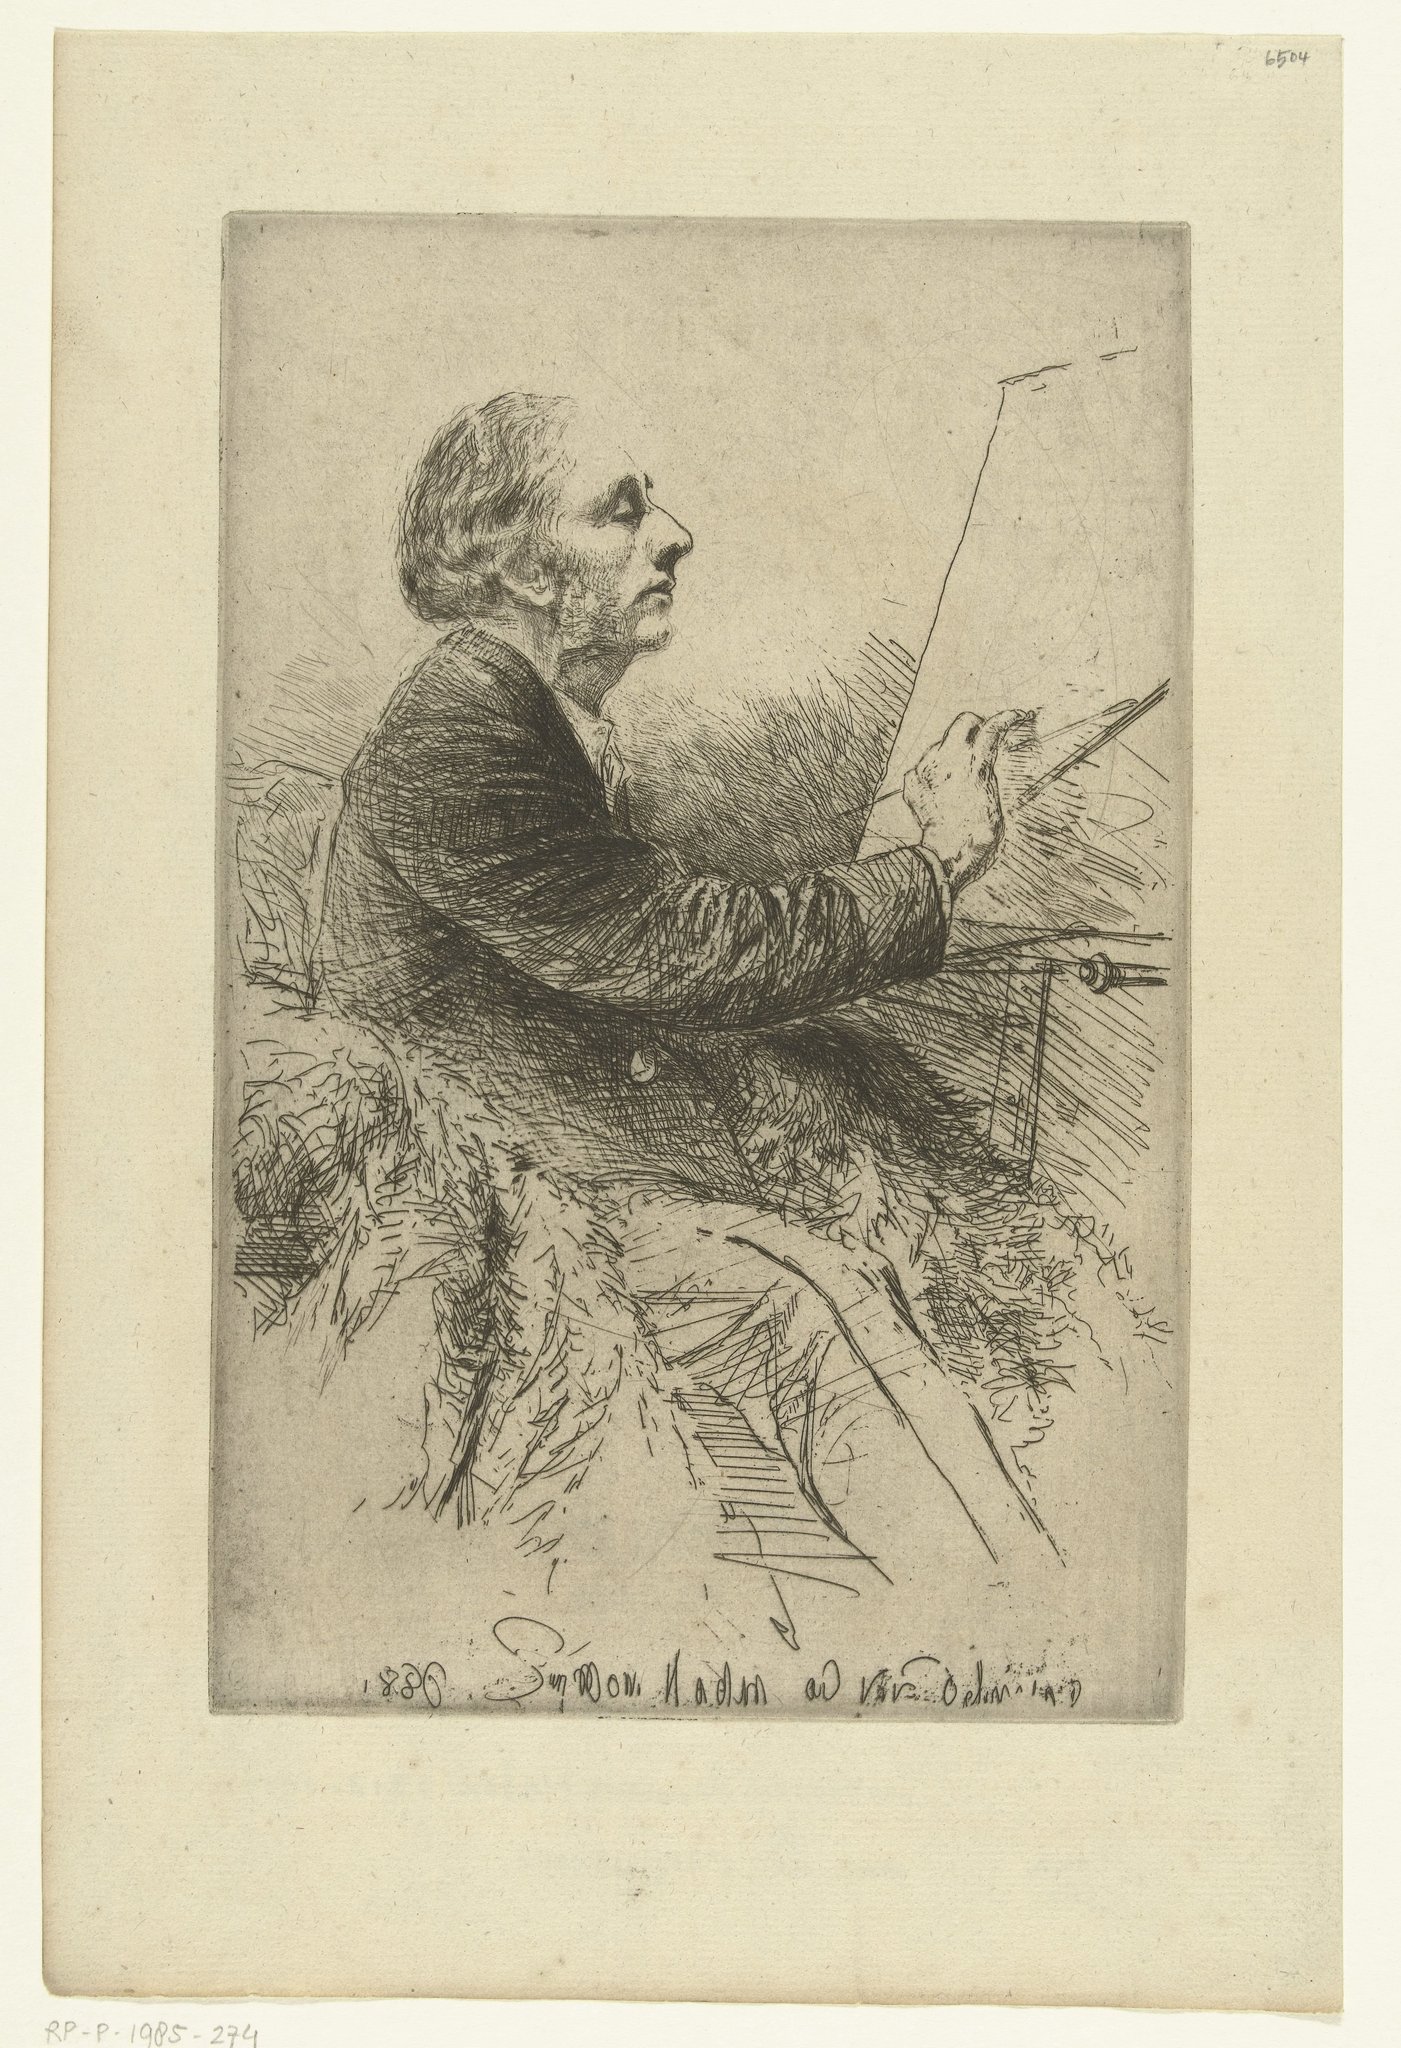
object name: print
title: Zelfportret van Francis Seymour-Haden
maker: francis seymour-haden (sir)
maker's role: print maker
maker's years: 1818-1910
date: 1880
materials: paper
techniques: etching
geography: england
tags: print maker, francis seymour-haden (sir), portrait, self-portrait of painter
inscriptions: collector's mark: Lugt 2760, collector's mark: Lugt 2228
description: Prent is gemaakt naar een foto, daarom is het opvallend dat Seymour-Haden op de prent heeft vermeld: ad viv[am] Deliniavit. Botke, K.